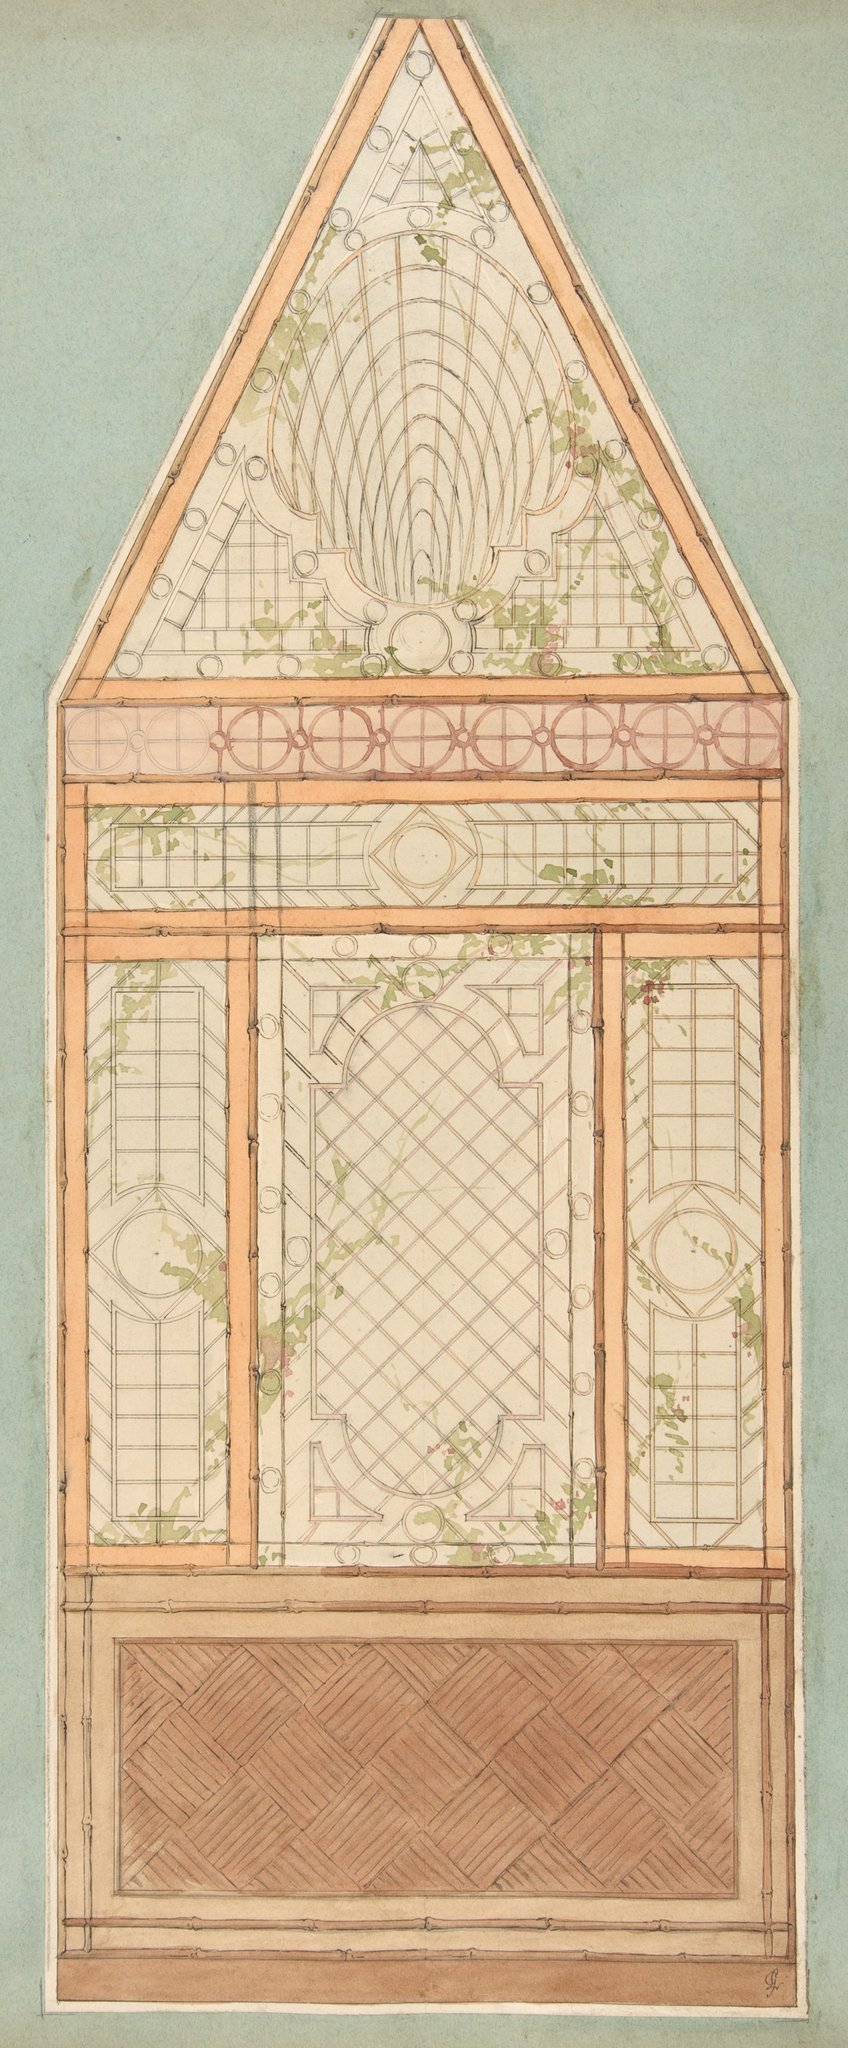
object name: drawing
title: Design for the treatment of a wall with a pattern of lattices, vines, and bamboo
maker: jules-edmond-charles lachaise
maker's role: artist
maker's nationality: french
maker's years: 1897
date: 1851-1900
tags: bamboo,leaves